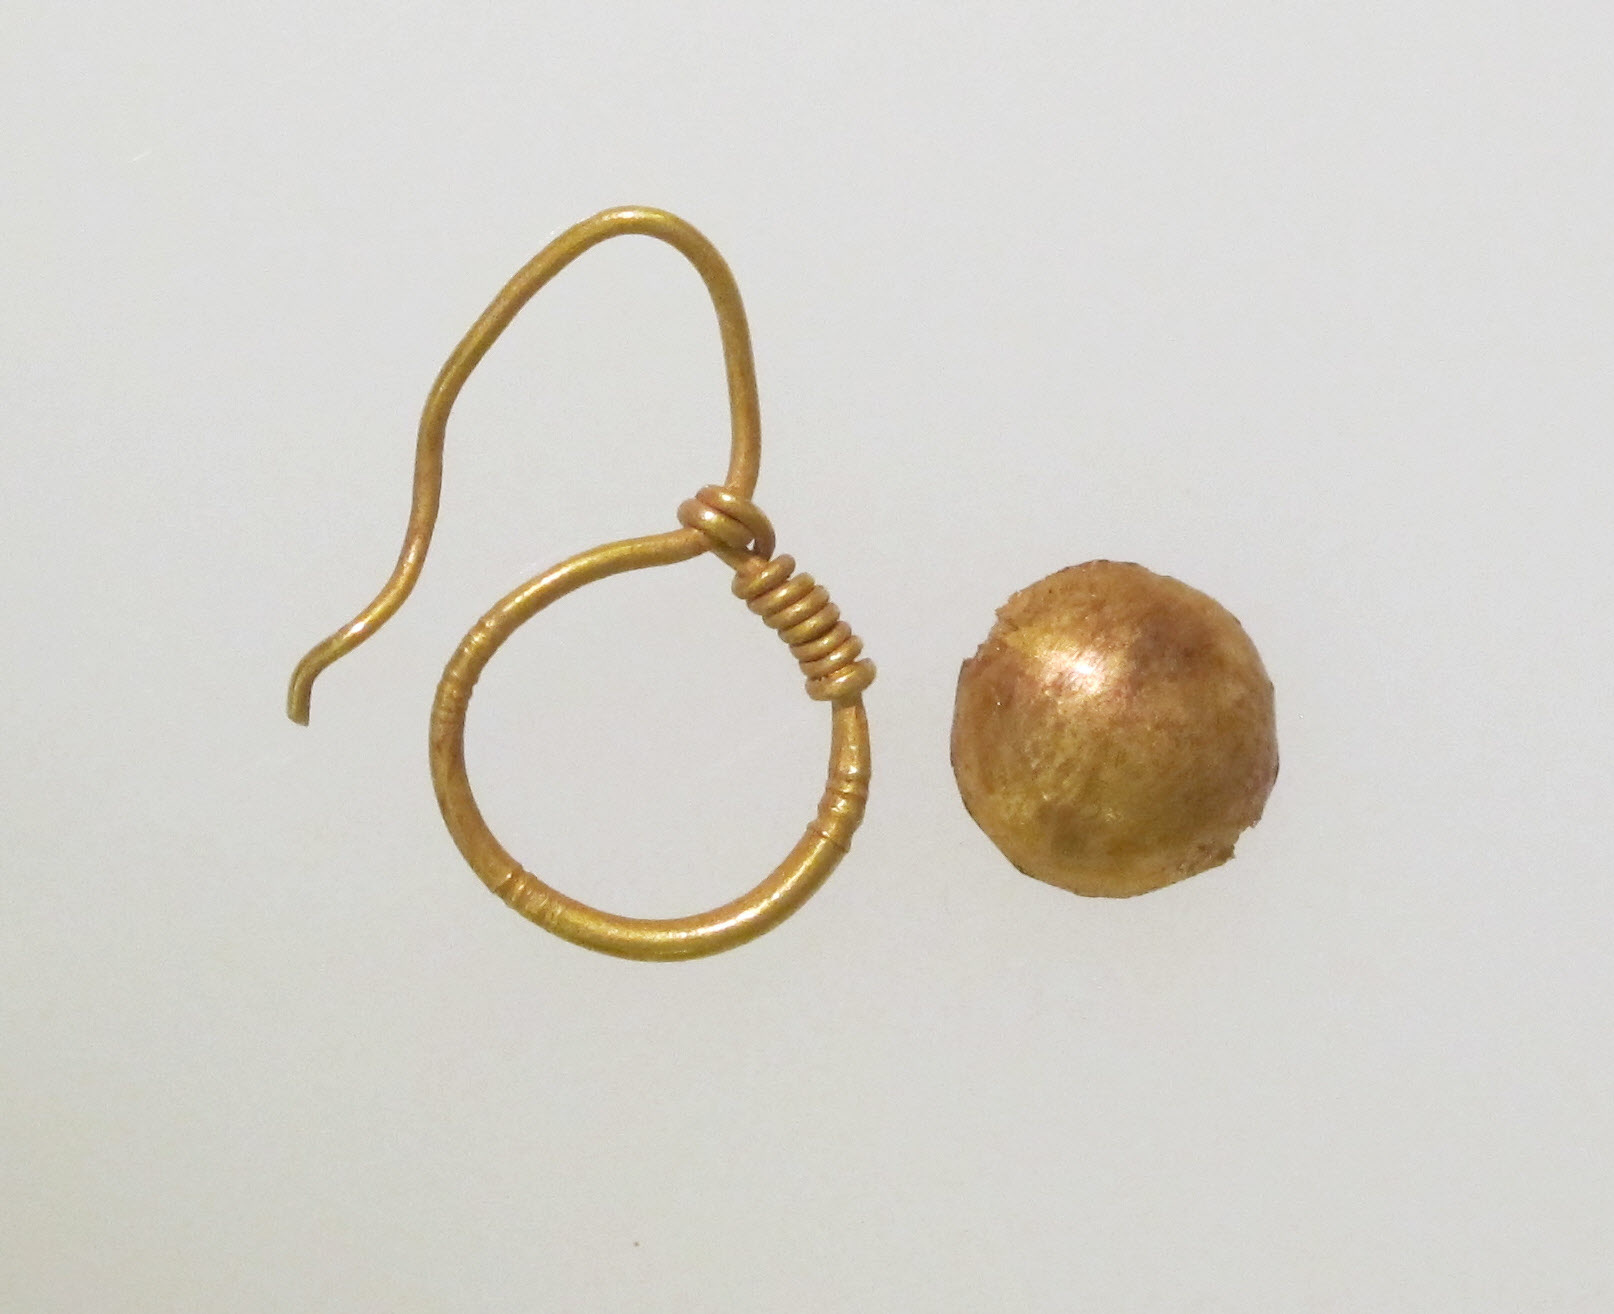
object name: earring, delta shaped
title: Earring, delta-shaped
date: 7000 BCE-330 CE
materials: gold